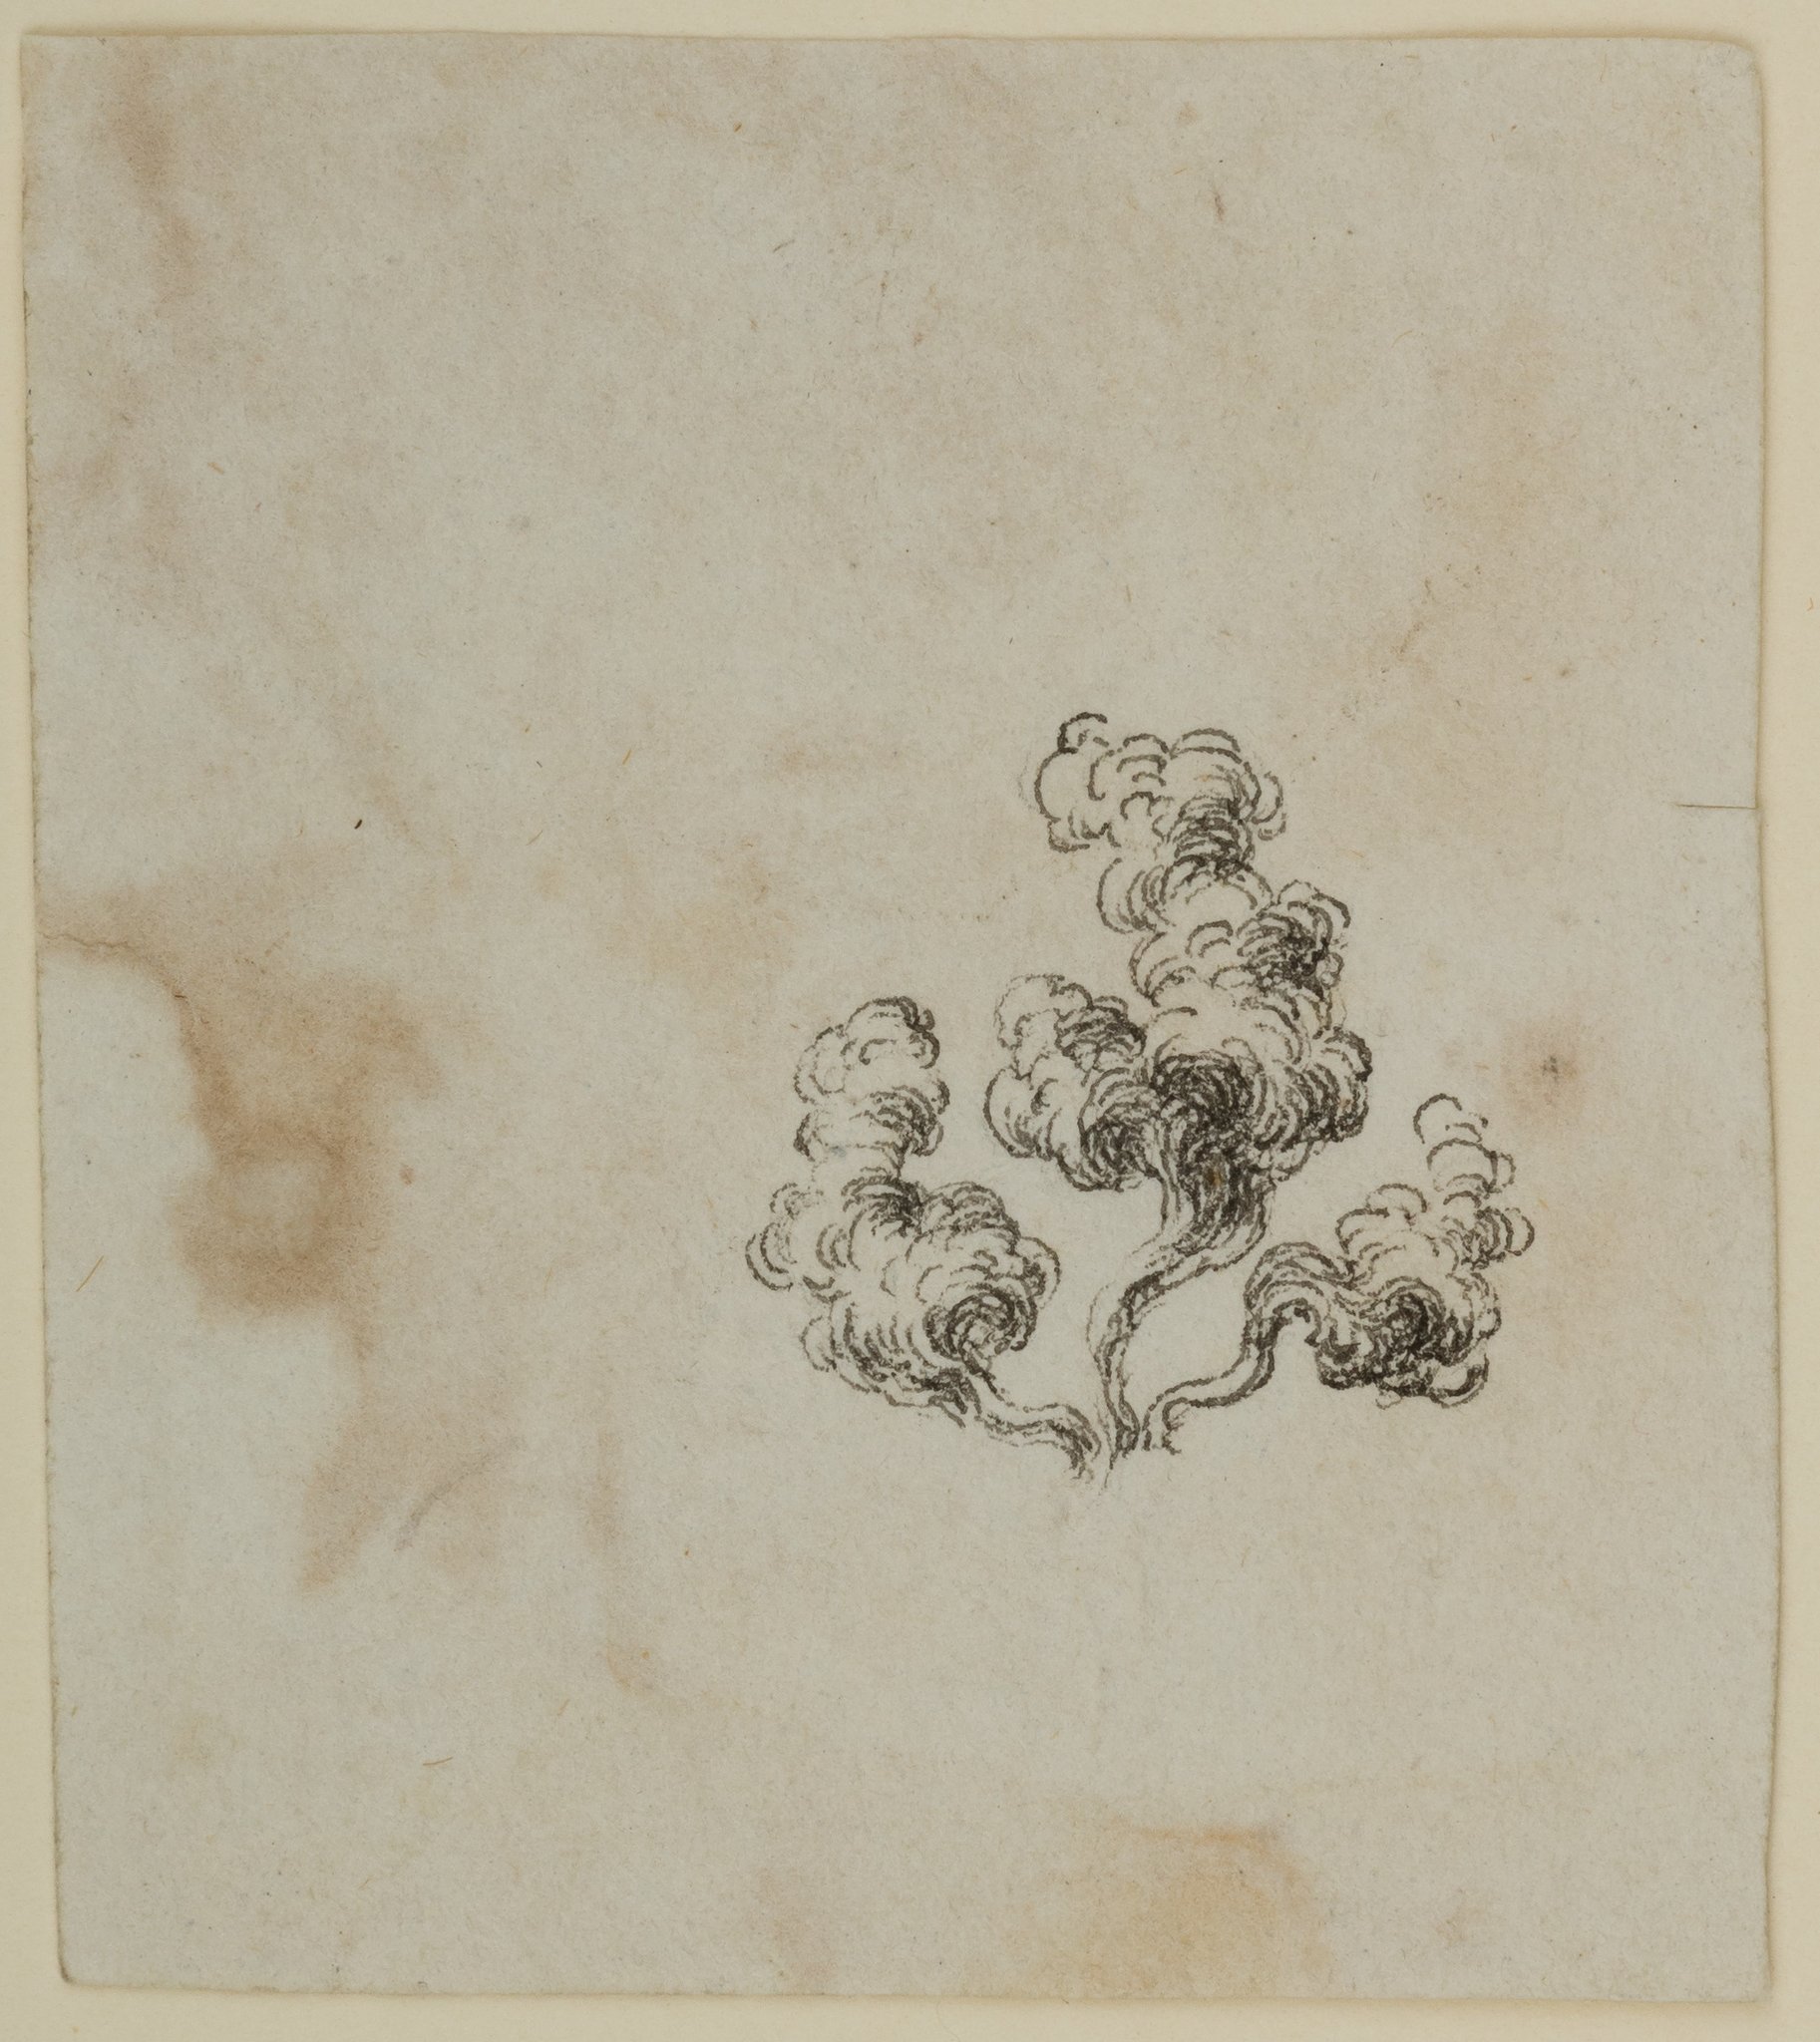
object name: drawing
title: Design for the Decoration of Firearms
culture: french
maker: nicolas noël boutet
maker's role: designer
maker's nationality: french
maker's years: 1761-1833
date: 1797-1805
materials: ink, paper, pencil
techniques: wash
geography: france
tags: ornament